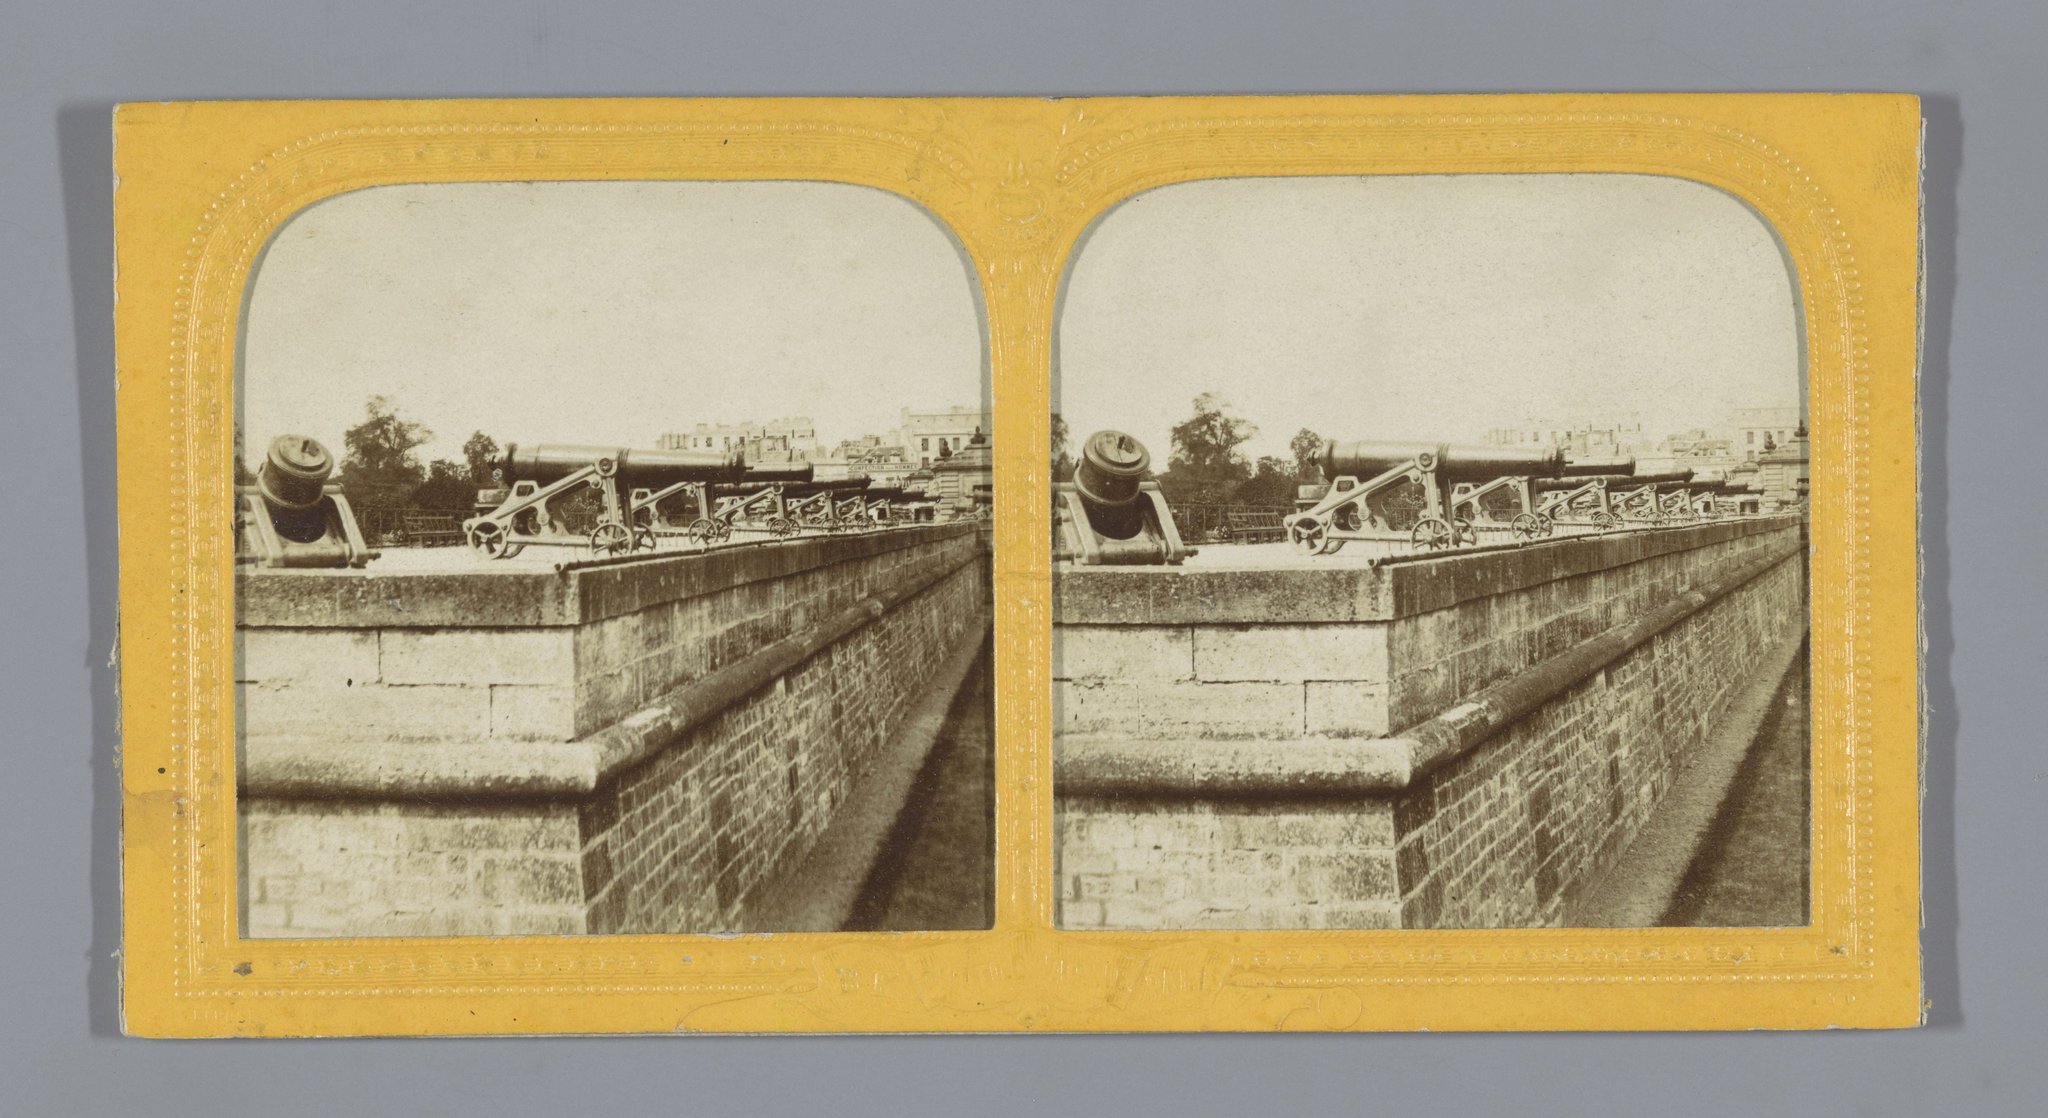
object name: tissue stereograph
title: Remparts des Invalides, Paris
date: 1863-1875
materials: cardboard, paper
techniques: albumen print, hand coloring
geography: paris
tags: bastion, bulwark, firearms: cannon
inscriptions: inscription: ‘Déposé’